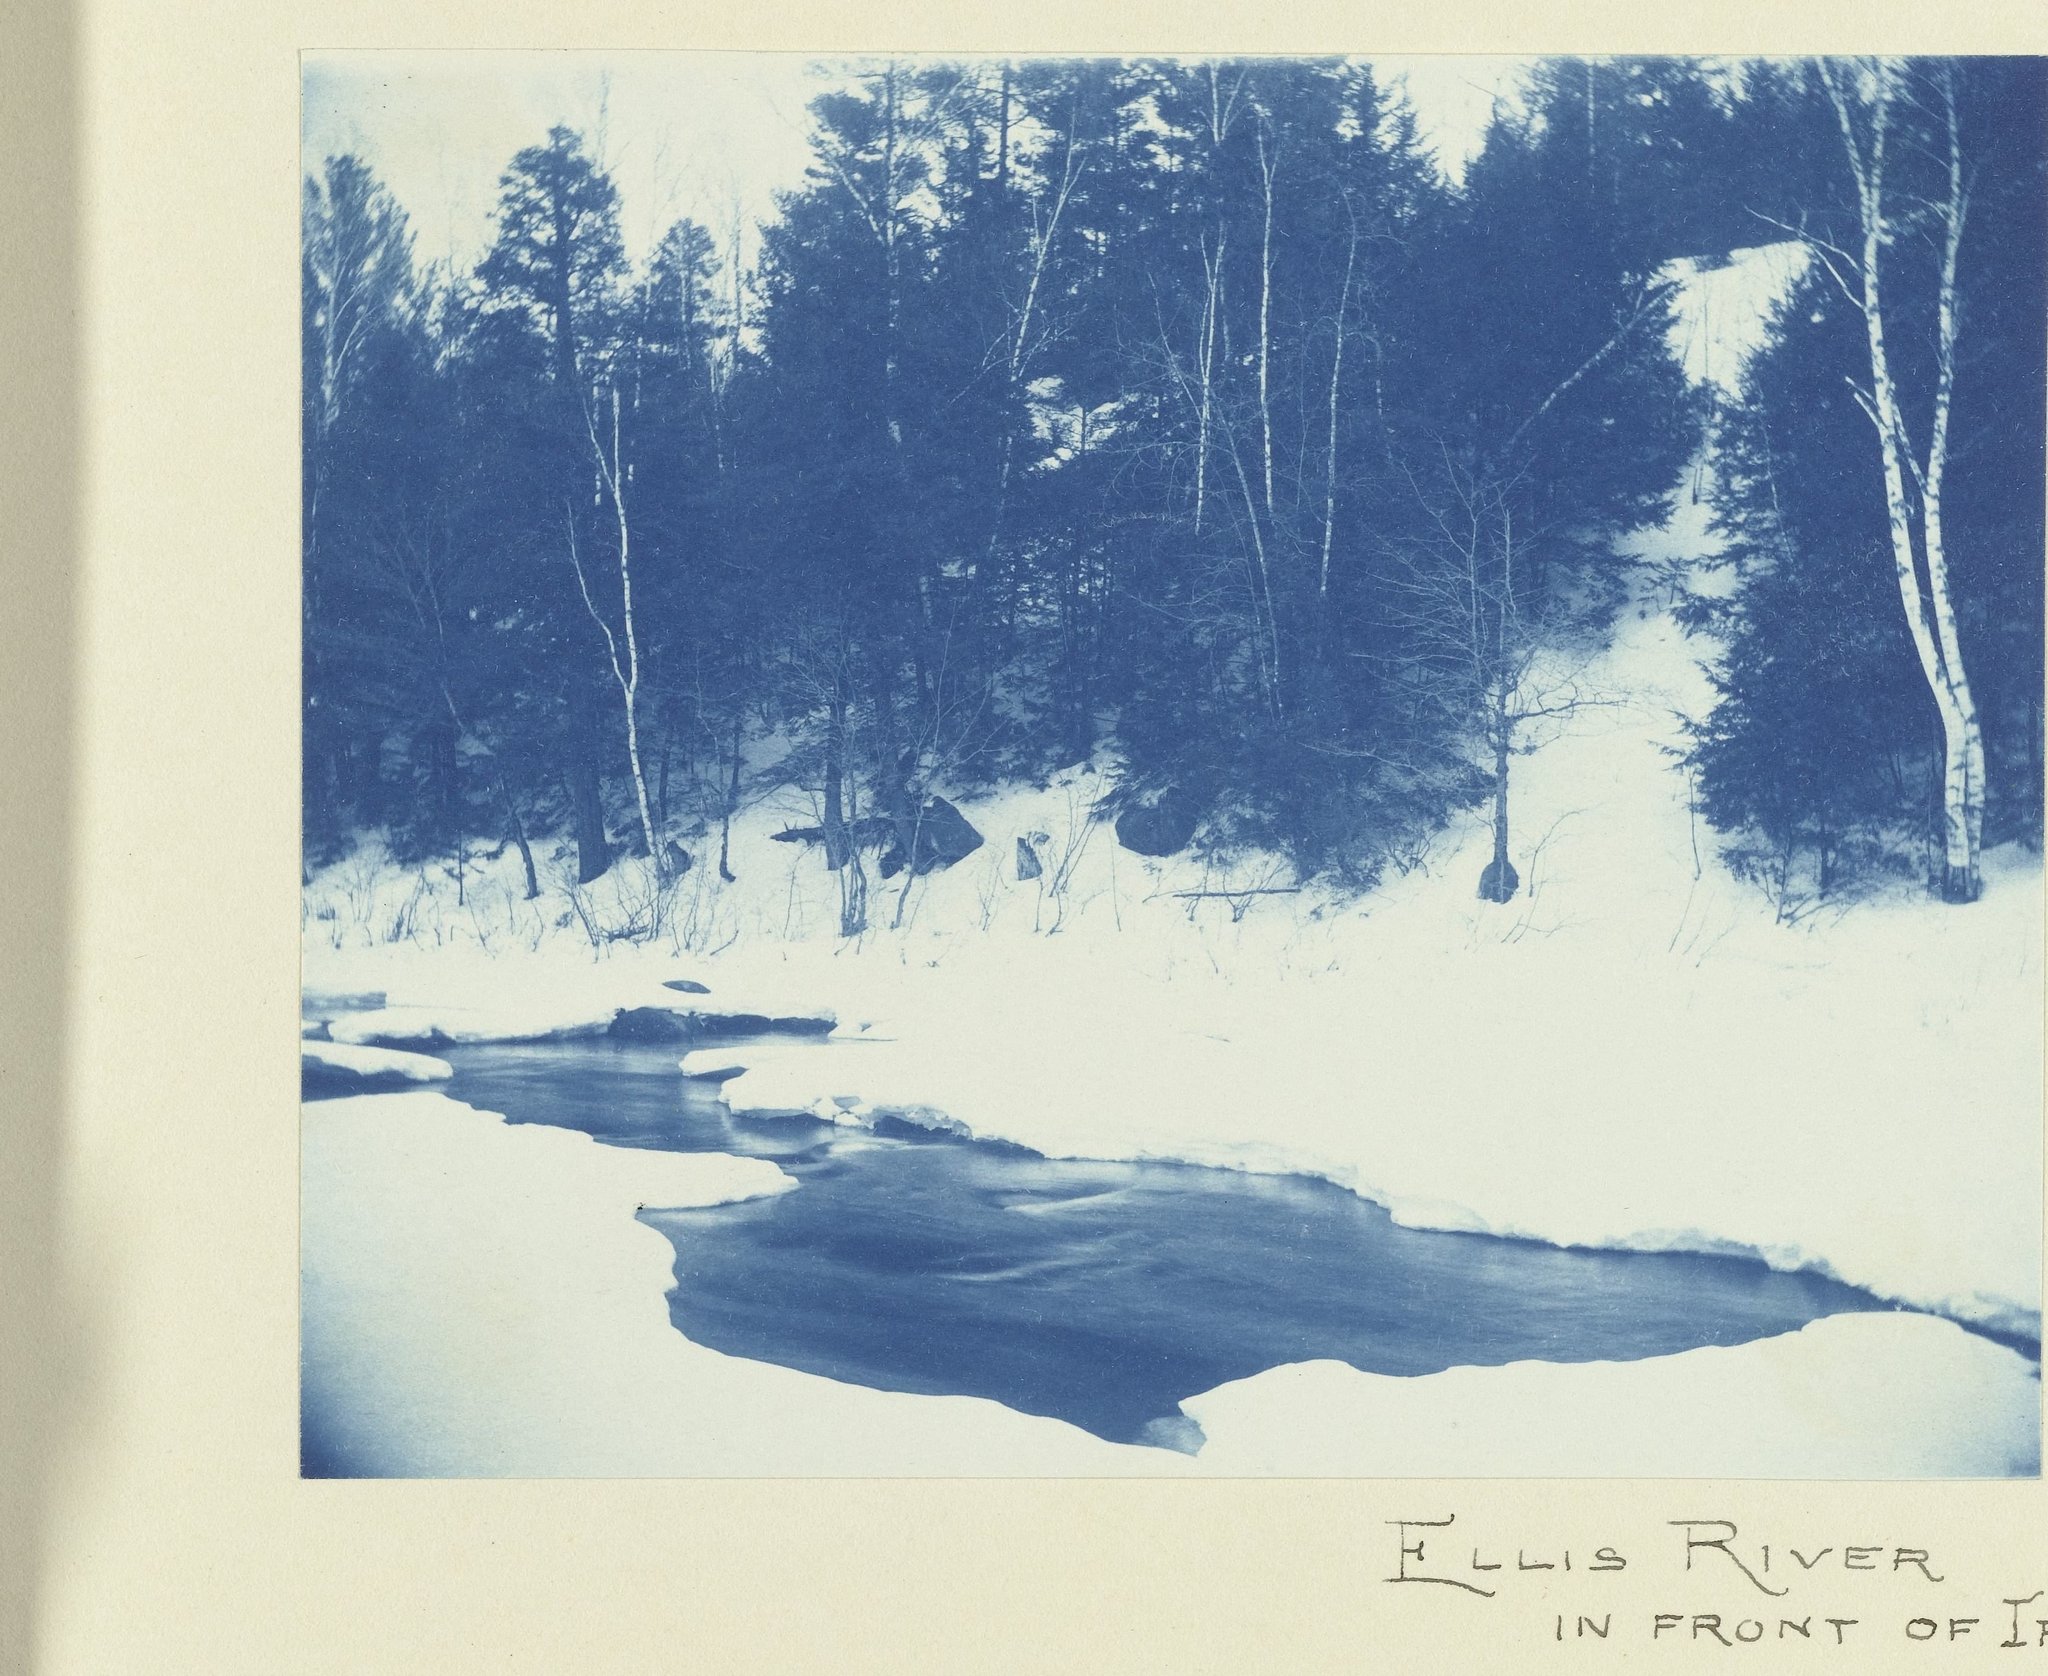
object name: photograph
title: Landschap in de sneeuw: Ellis River bij Iron Mountain House, NH, Verenigde Staten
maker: charlotte m. endicott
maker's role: fotograaf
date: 1899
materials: photographic support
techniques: cyanotype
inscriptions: title: ‘ELLIS RIVER / IN FRONT OF IRON MT. HOUSE./ FEB. 22. 1899.’